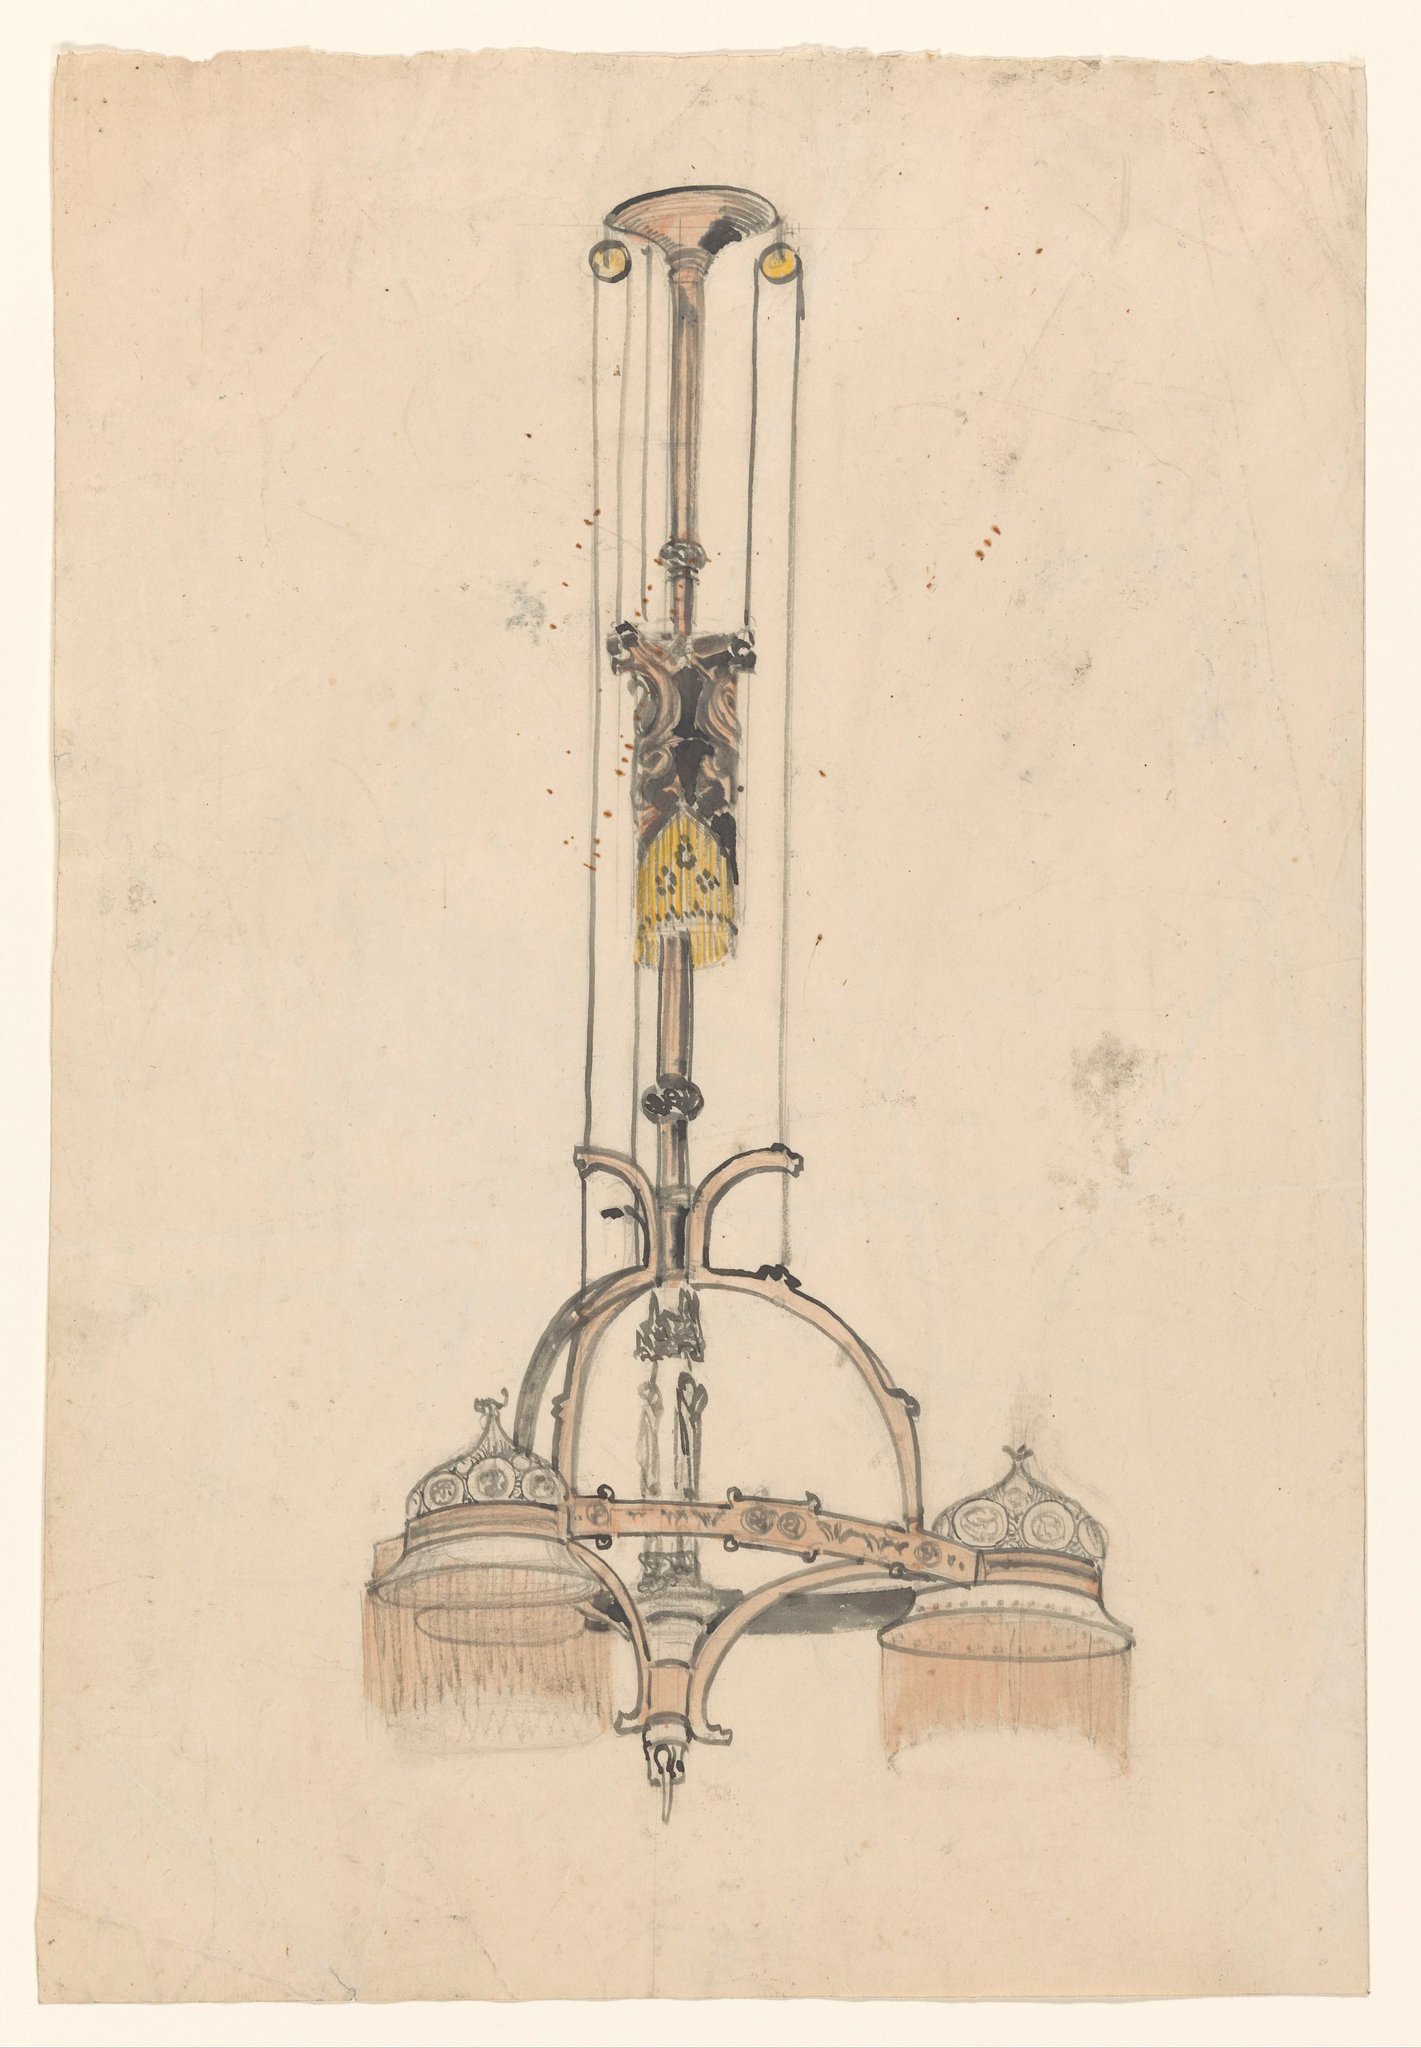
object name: design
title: Ontwerp voor een bascule lamp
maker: carel adolph lion cachet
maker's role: draughtsman, print maker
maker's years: 1864-1945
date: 1874-1945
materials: ink, paper, pencil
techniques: brush, pen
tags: lighting; lamps